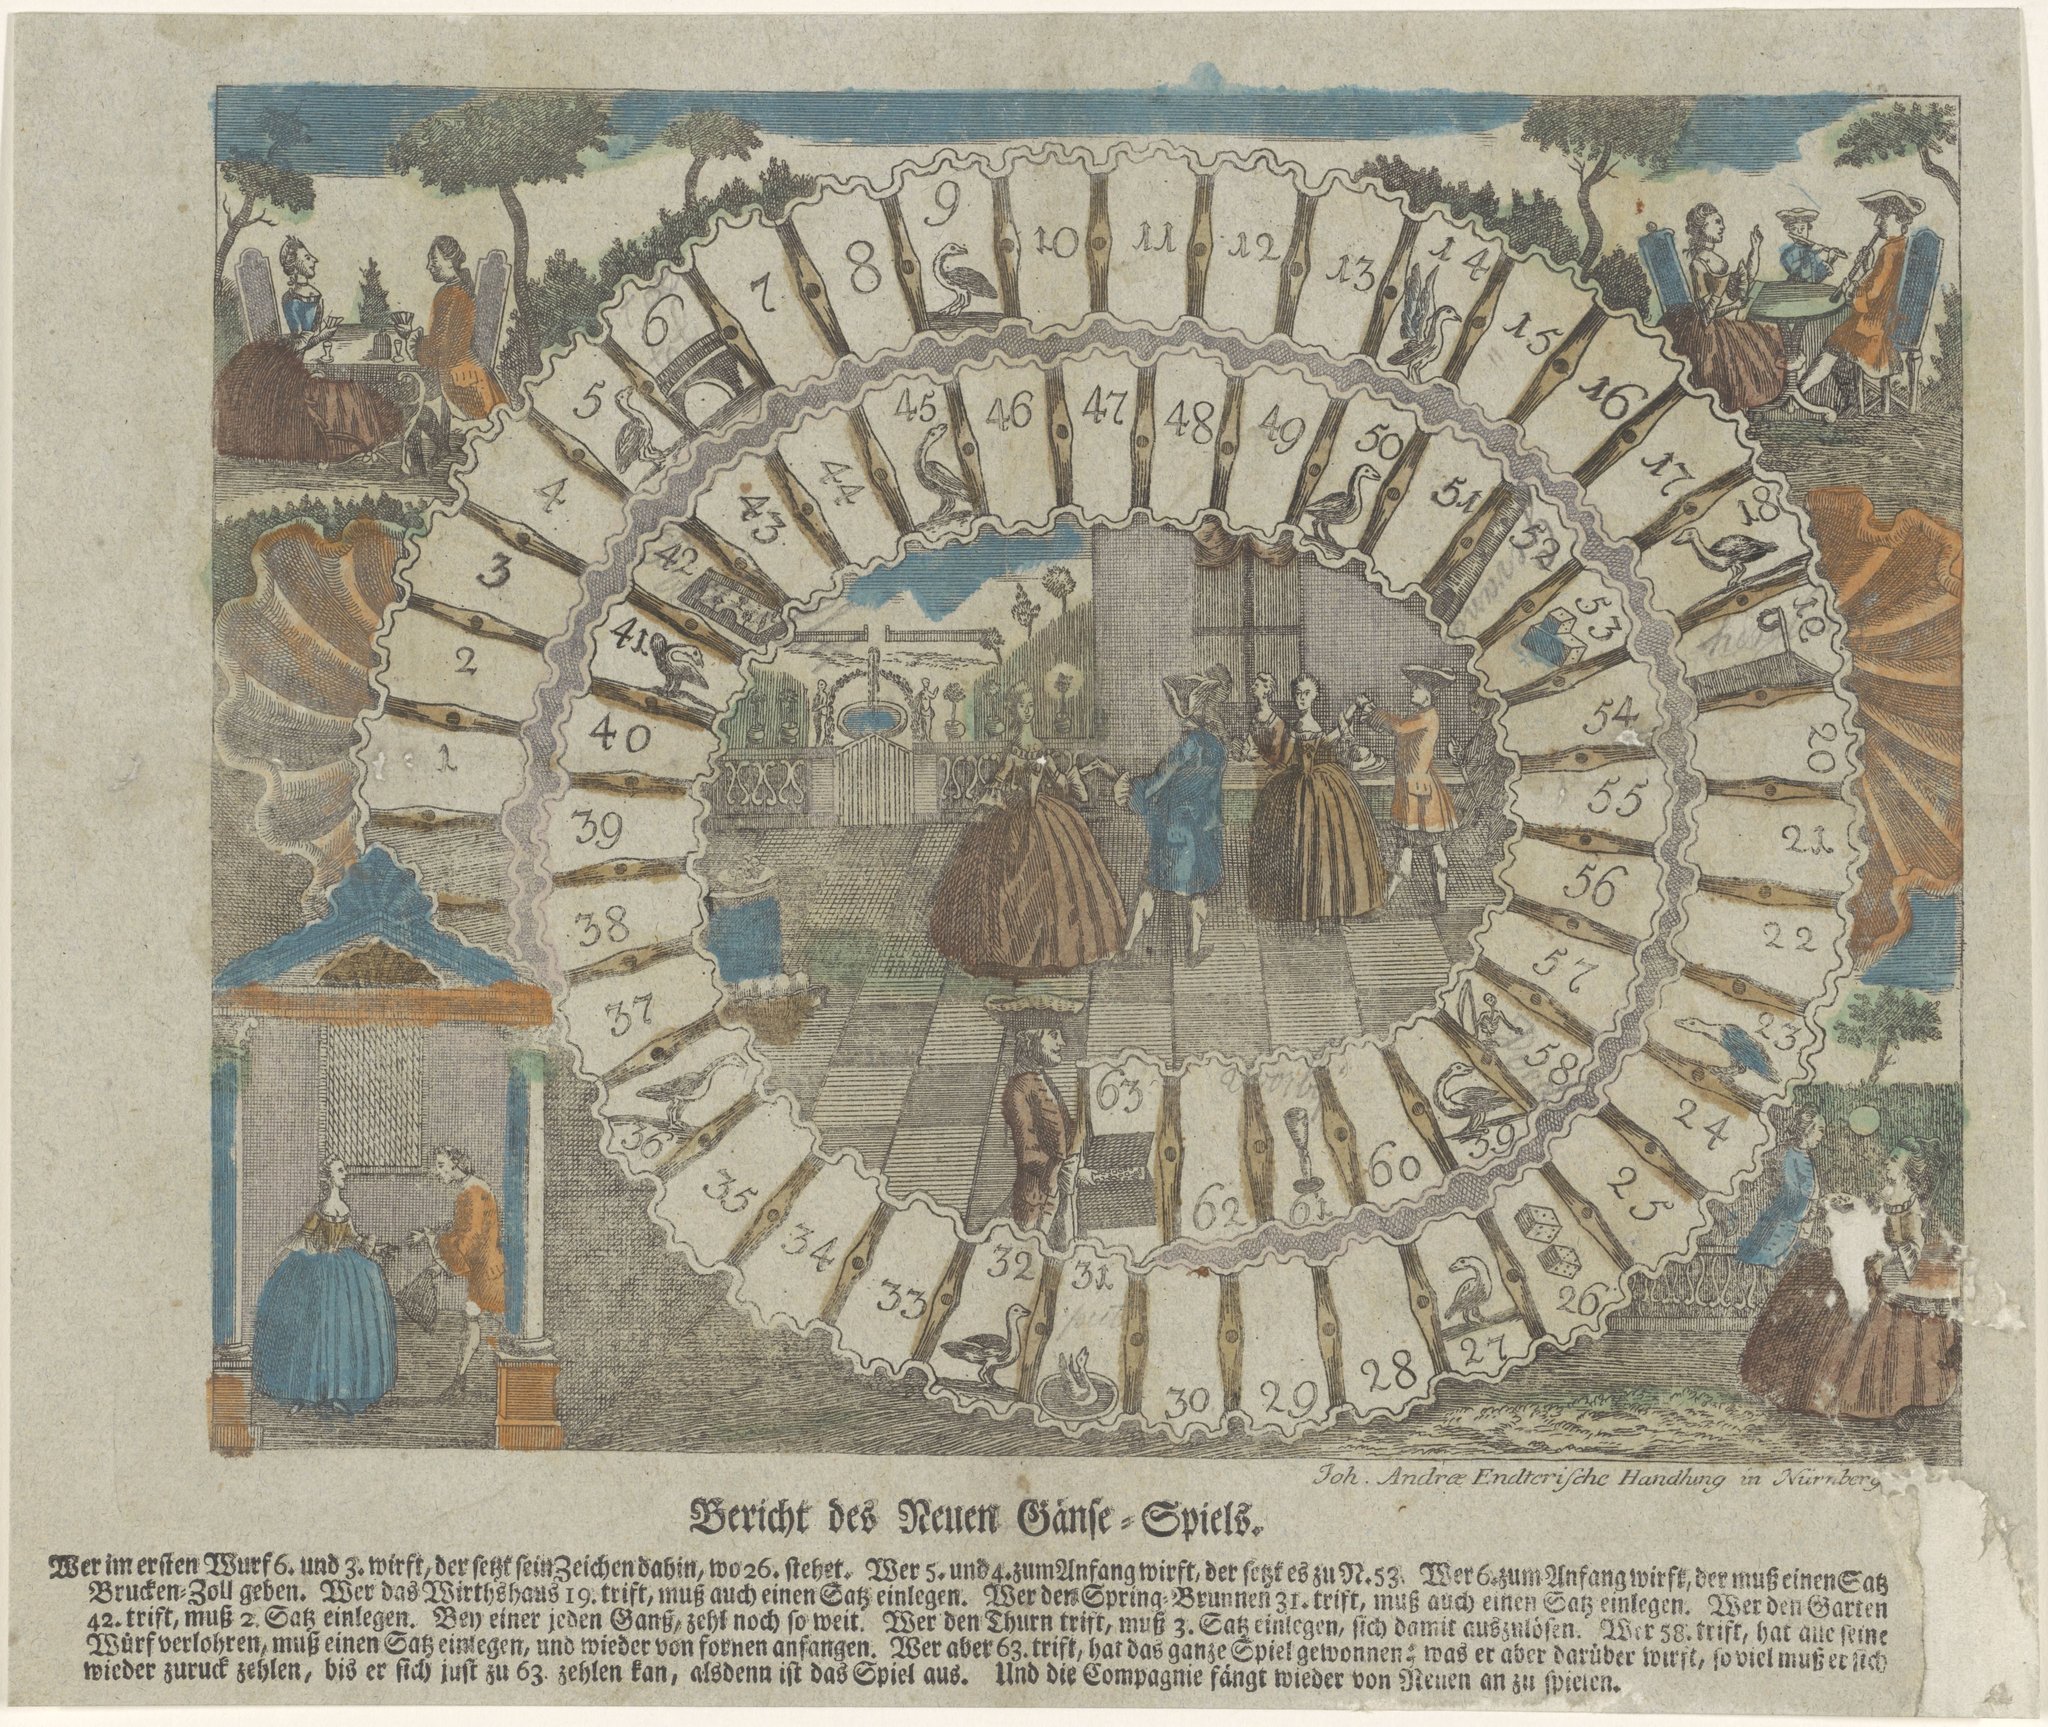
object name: game of goose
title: Ganzenbord, ca. 1830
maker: Anonymous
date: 1820-1850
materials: paper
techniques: etching, hand coloring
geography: nuremberg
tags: board-games of chance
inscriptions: collector's mark: Lugt 2228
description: Duits ganzenbordspel. In het midden en in de vier hoeken plaatjes van elegante mannen en vrouwen. Onderaan de spelregels. Onderdeel van een groep van kinder- en gezelschapsspelen gedrukt in de periode ca. 1750-1850.